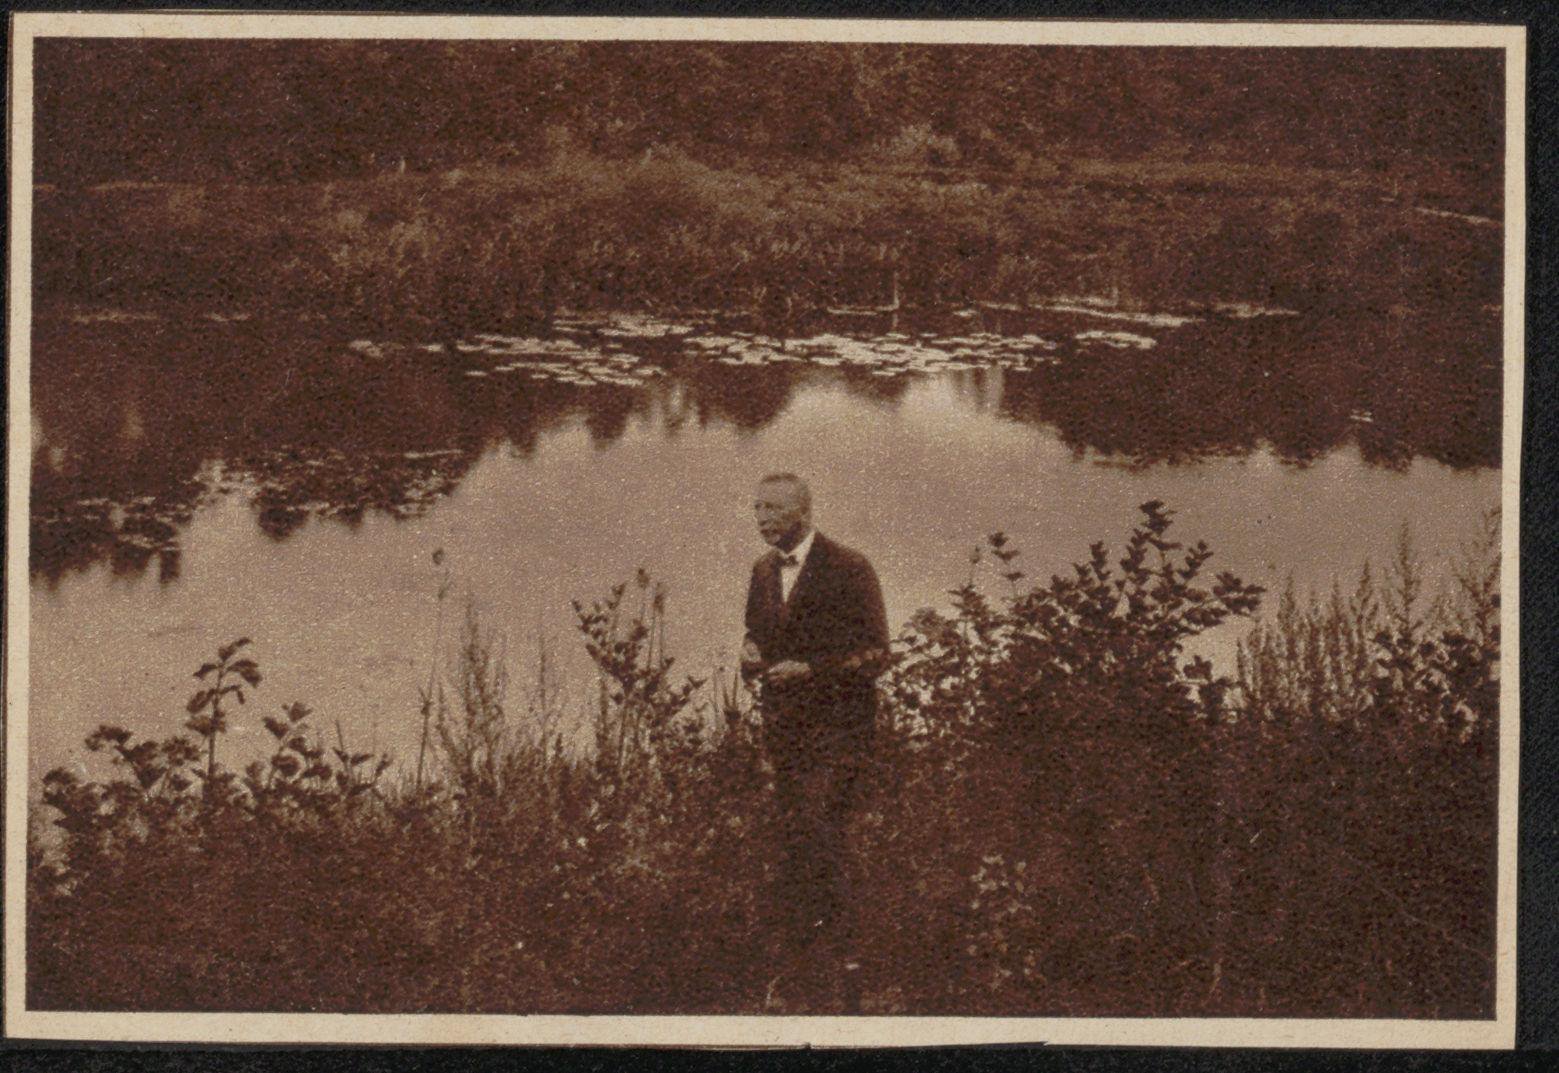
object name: newspaper clipping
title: Krantenknipsel betreffende Jac. P. Thijsse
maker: Anonymous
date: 1910-1949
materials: paper, ink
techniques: printing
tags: jac. p. thijsse, historical persons (portraits and scenes from the life)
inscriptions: collector's mark: ‘RPK’